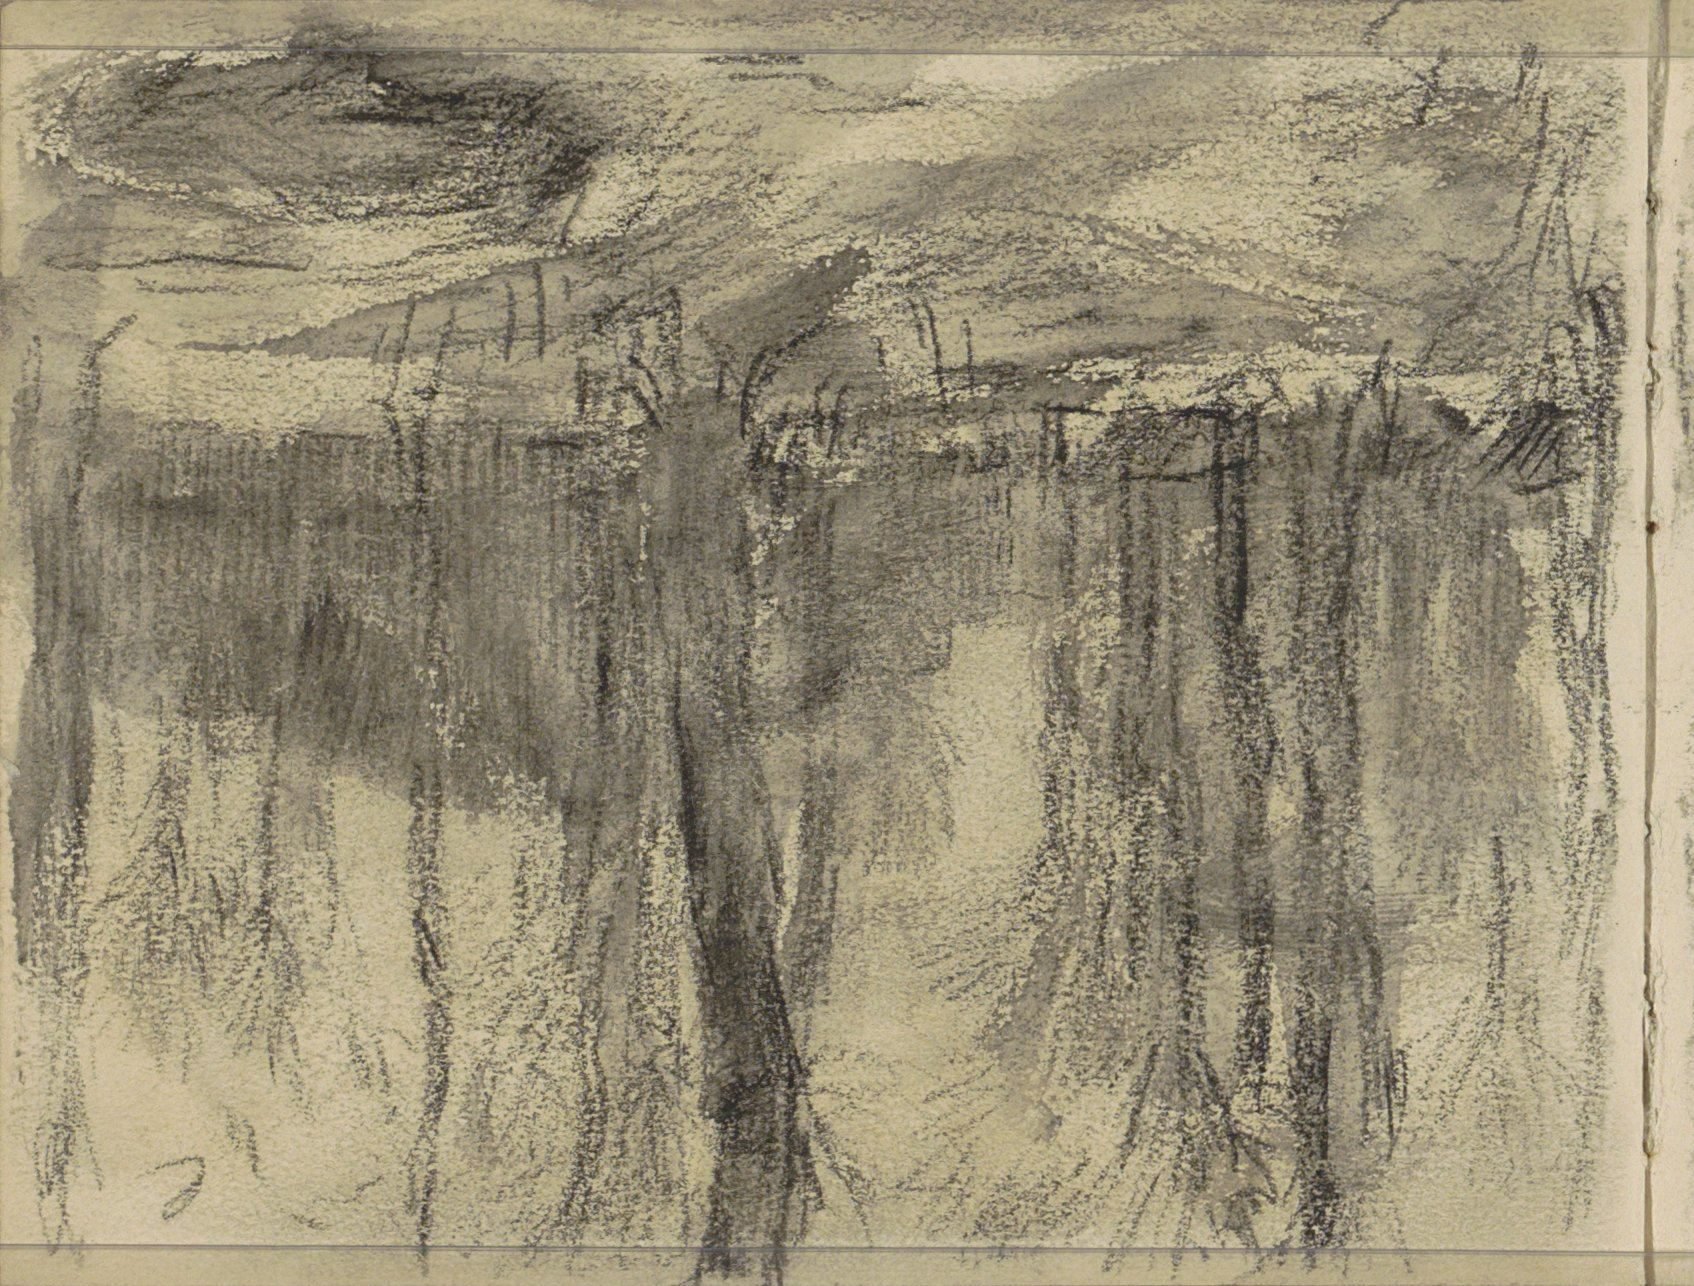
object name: sketchbook leaf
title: Landschap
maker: johan antonie de jonge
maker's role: draughtsman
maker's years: 1864-1927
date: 1881-1927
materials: chalk, paper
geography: south holland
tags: landscapes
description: Landschap. Blad 34 verso uit een schetsboek met 34 bladen.